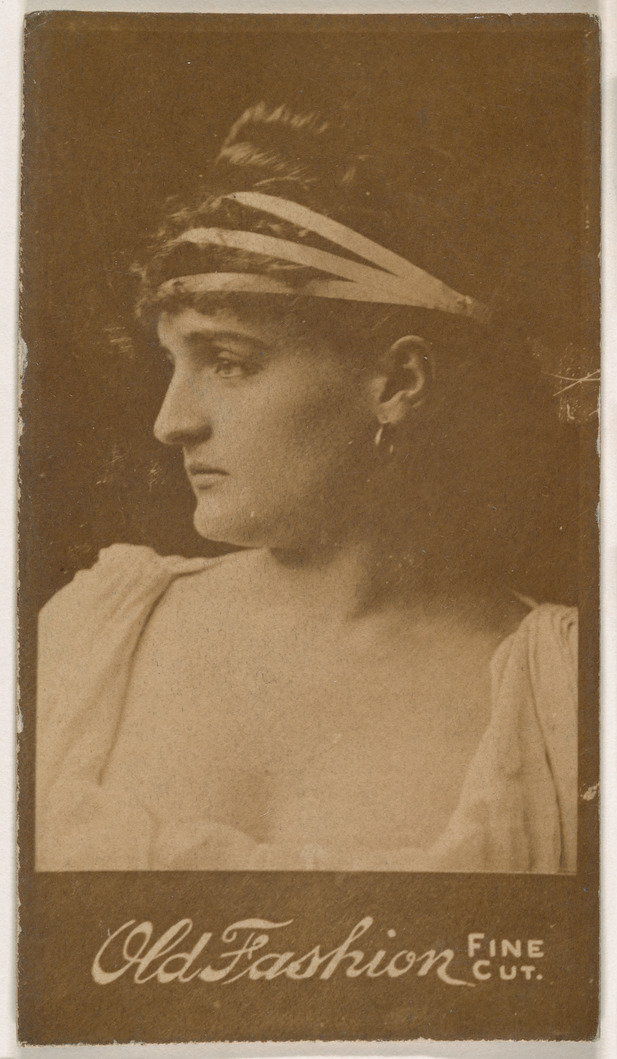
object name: photograph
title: Actress in profile, from the Actresses series (N664) promoting Old Fashion Fine Cut Tobacco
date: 1888-1890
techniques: albumen silver print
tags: portraits,profiles,women,actresses